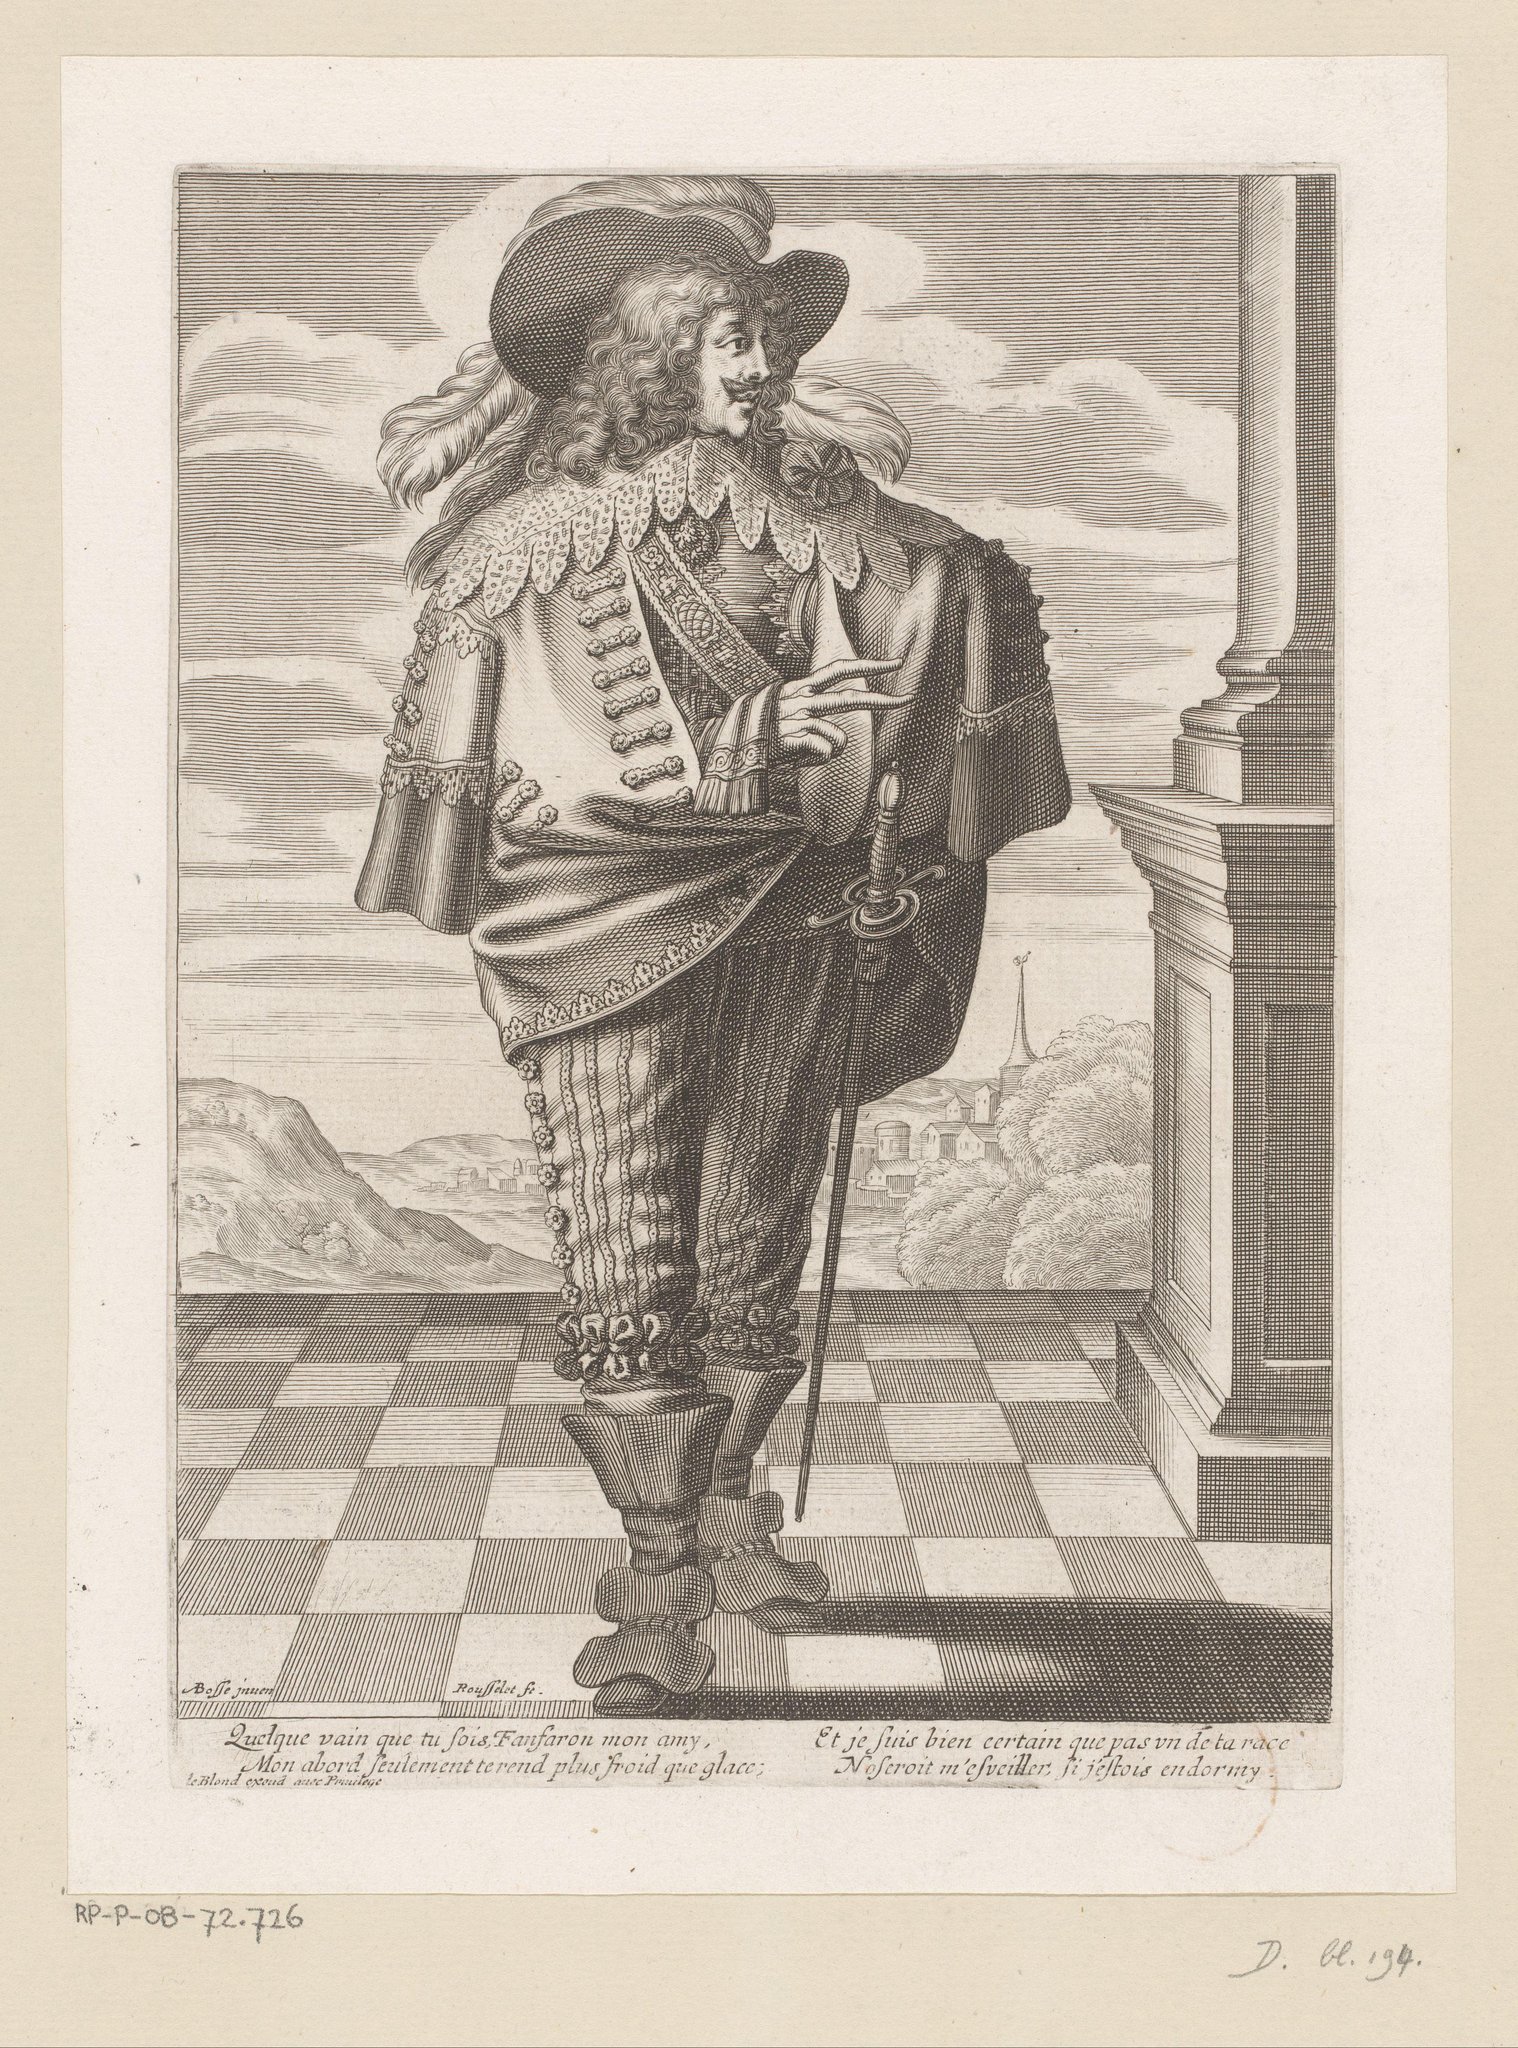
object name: print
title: Edelman staand op een terras, op de achtergrond een landschap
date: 1635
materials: paper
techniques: engraving, etching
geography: france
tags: trousers, breeches (+ men's clothes), clothing for the upper part of the body (with name) (+ men's clothes), adult man, head-gear: hat (+ men's clothes), hacking and thrusting weapons: sword, clothes, costume (+ men's clothes), clothing for the upper part of the body (doublet) (+ men's clothes), boots (+ men's clothes), styles of hairdress (+ male human being (not to be used where -a- is prescribed))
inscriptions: collector's mark: Lugt 240, collector's mark: Lugt 1838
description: Edelman, gekleed volgens de mode van ca. 1625, staand op een terras naast een zuil. Op het lange gekrulde haar een hoed met brede rand en veren. Hij draagt een wambuis waarover een brede geschulpte kanten kraag en een losse schoudermantel. Gestreepte kniebroek en laarzen met sporen. Een degen langszij.